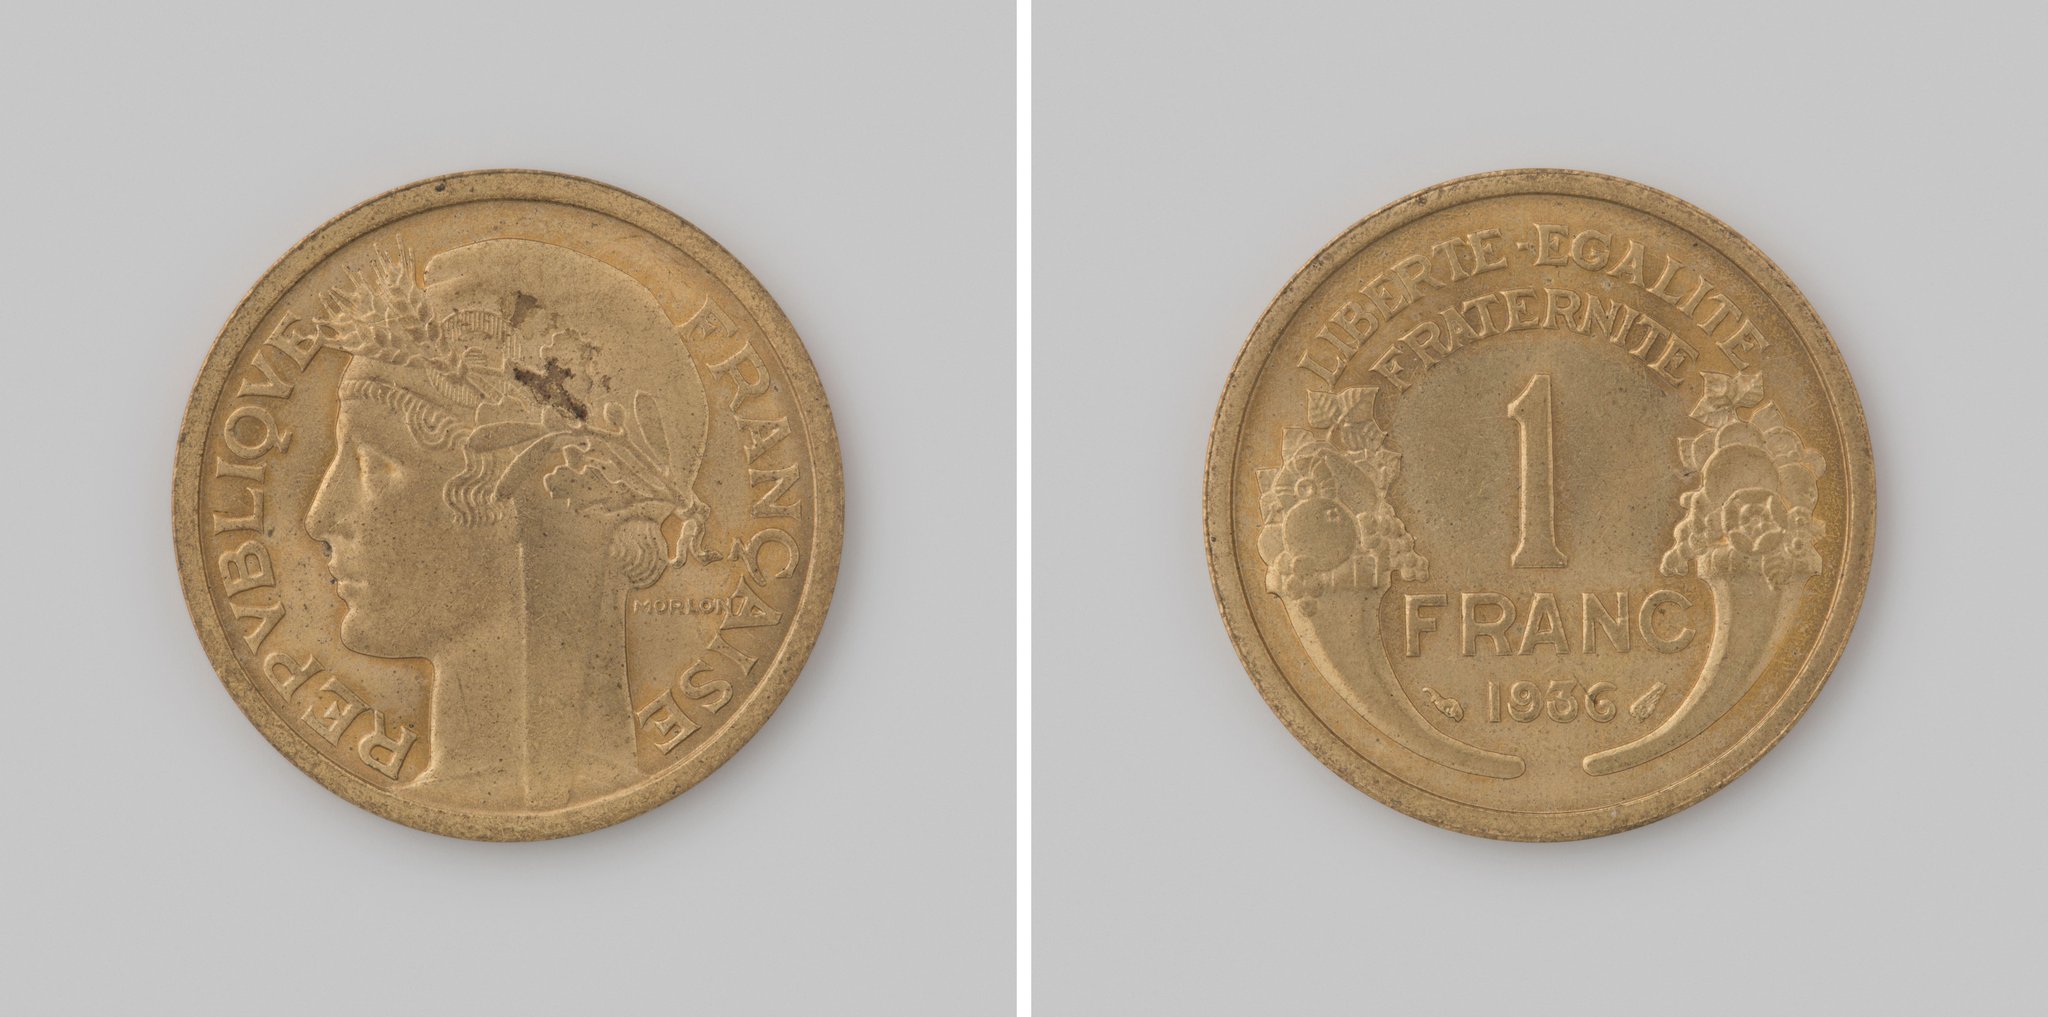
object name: coin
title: Frankrijk, Derde Republiek, franc, 1936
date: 1936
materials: bronze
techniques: striking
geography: paris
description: Aluminium-bronzen munt. Voorzijde: hoofd van een vrouw met krans in het haar naar links. Keerzijde: tussen twee hoornen des overvloeds waarde-aanduiding in twee regels, waaronder jaartal. Gladde rand.